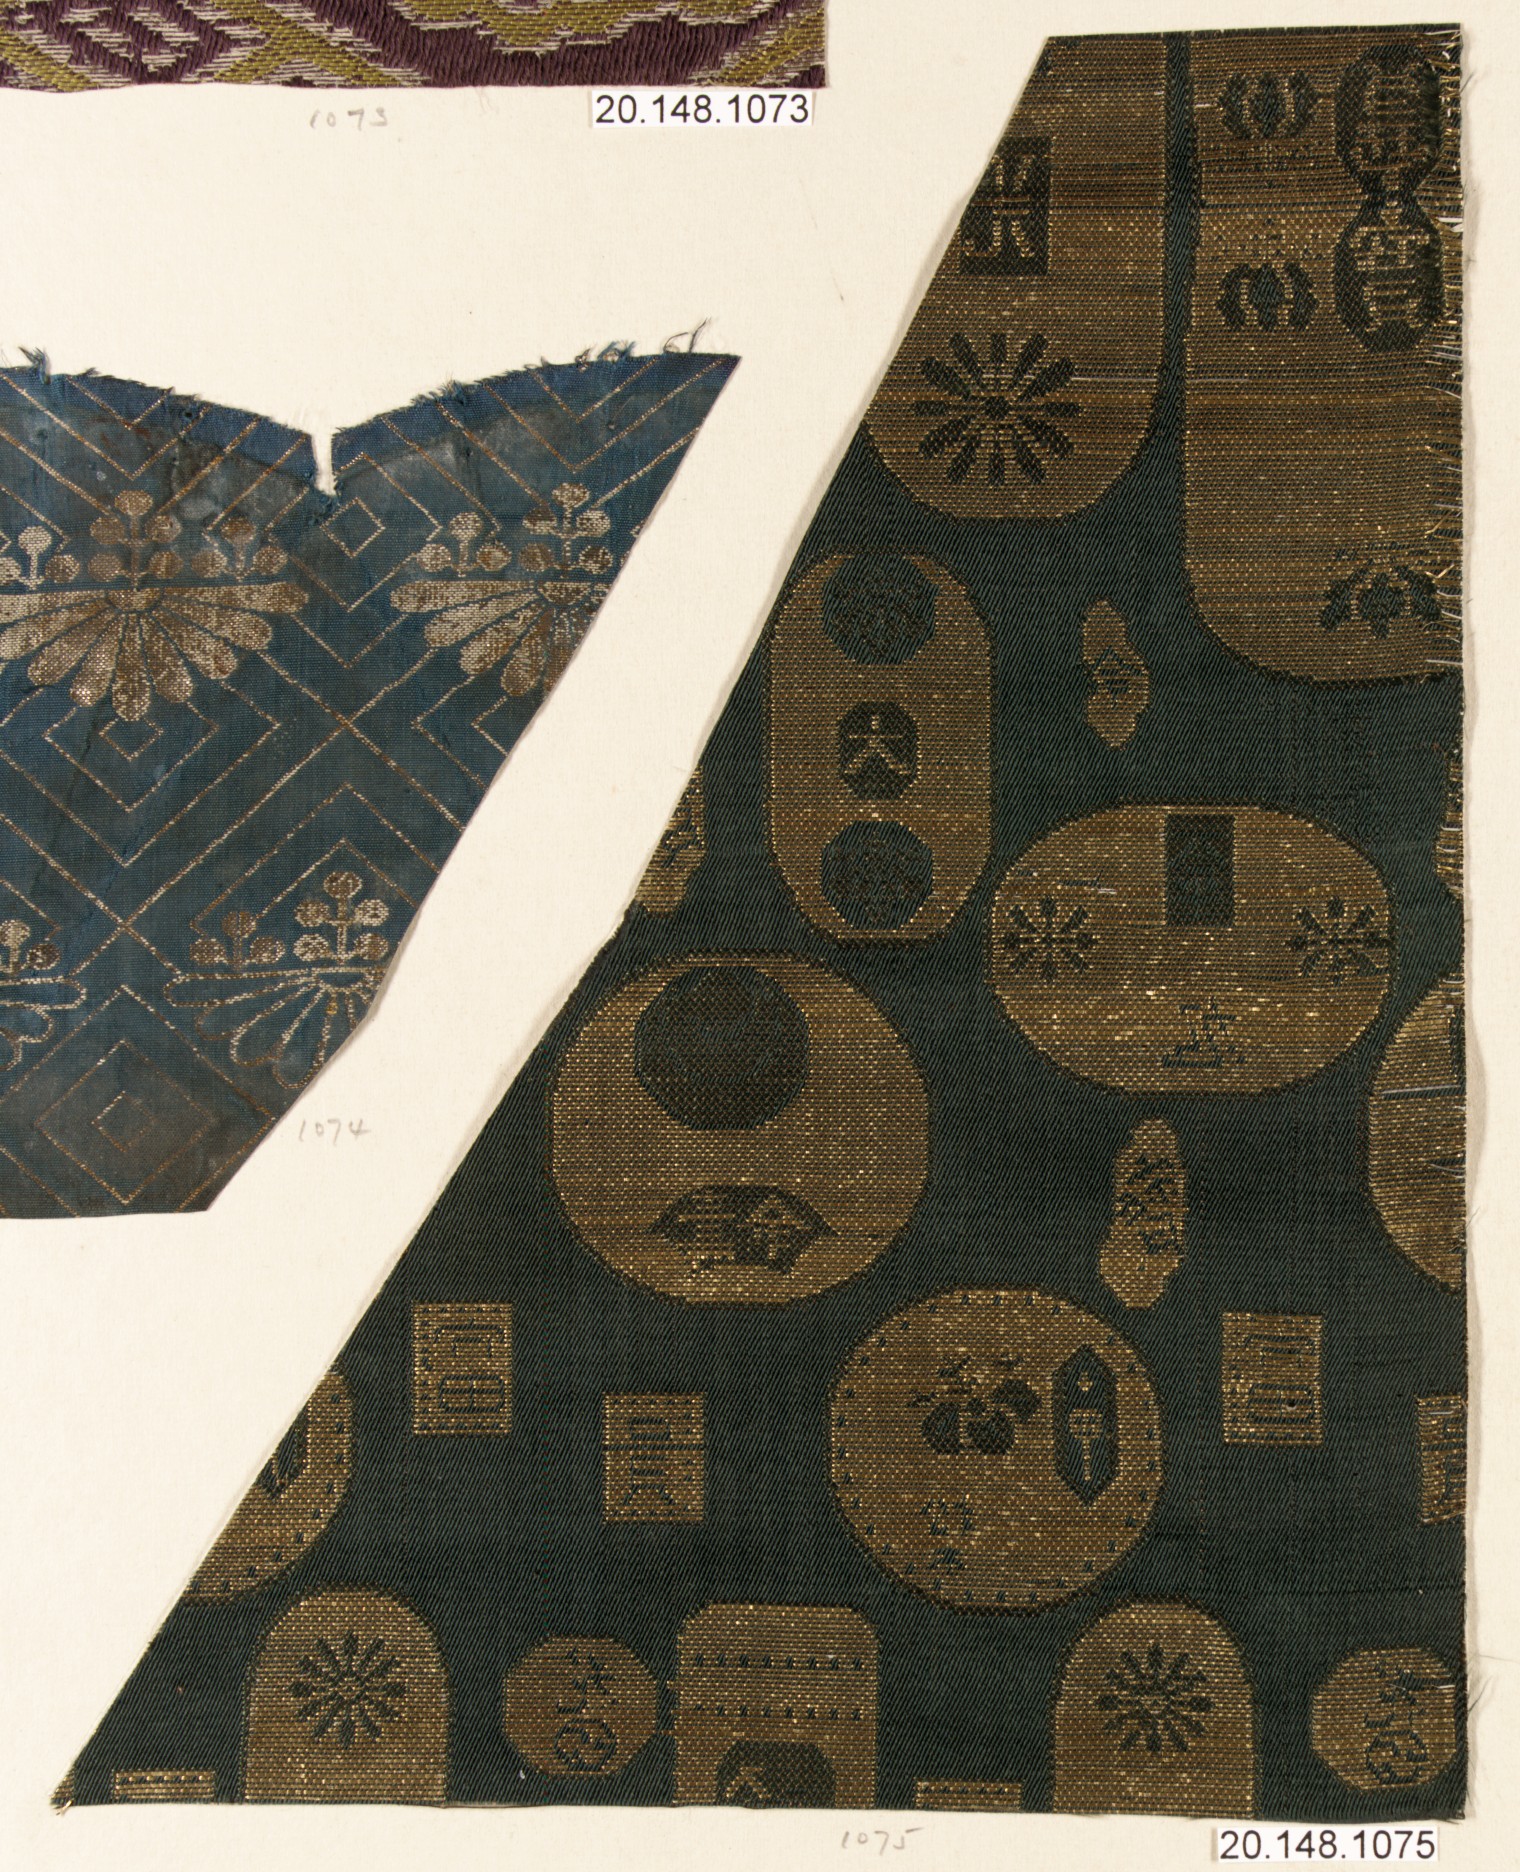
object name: piece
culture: japanese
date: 1701-1800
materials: silk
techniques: compound weave